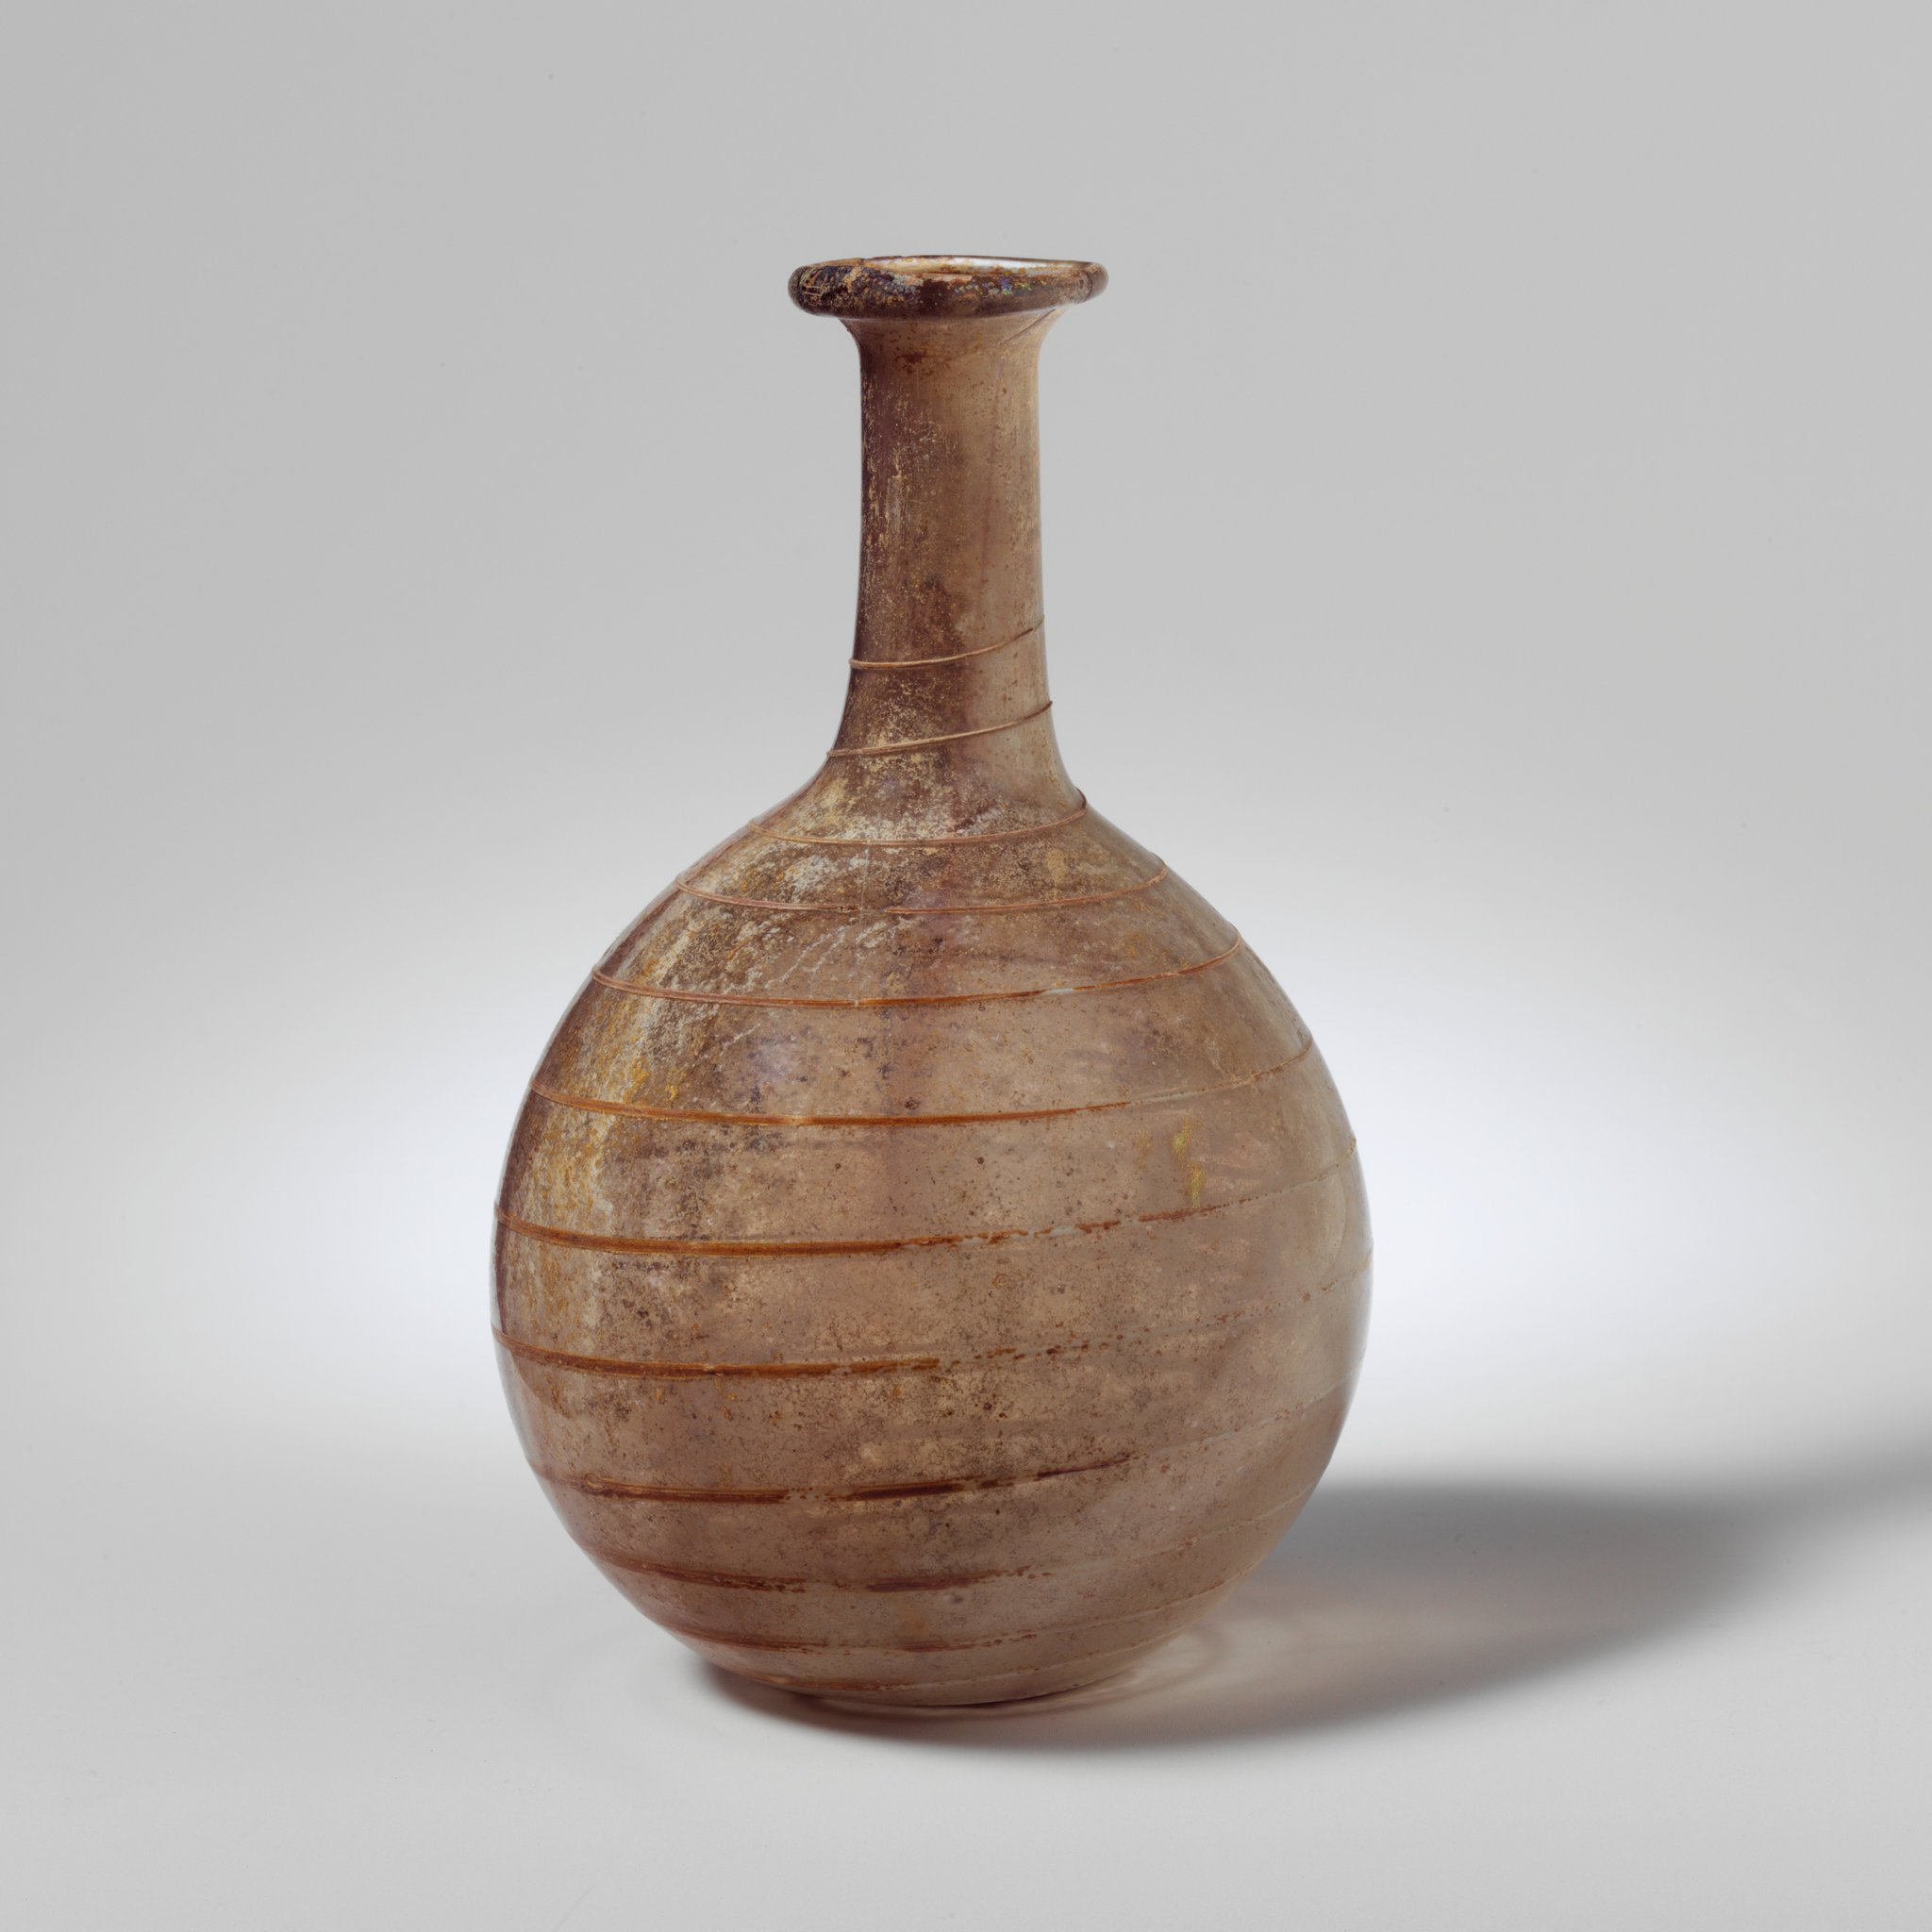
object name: perfume bottle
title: Glass perfume bottle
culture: roman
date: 1-100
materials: glass